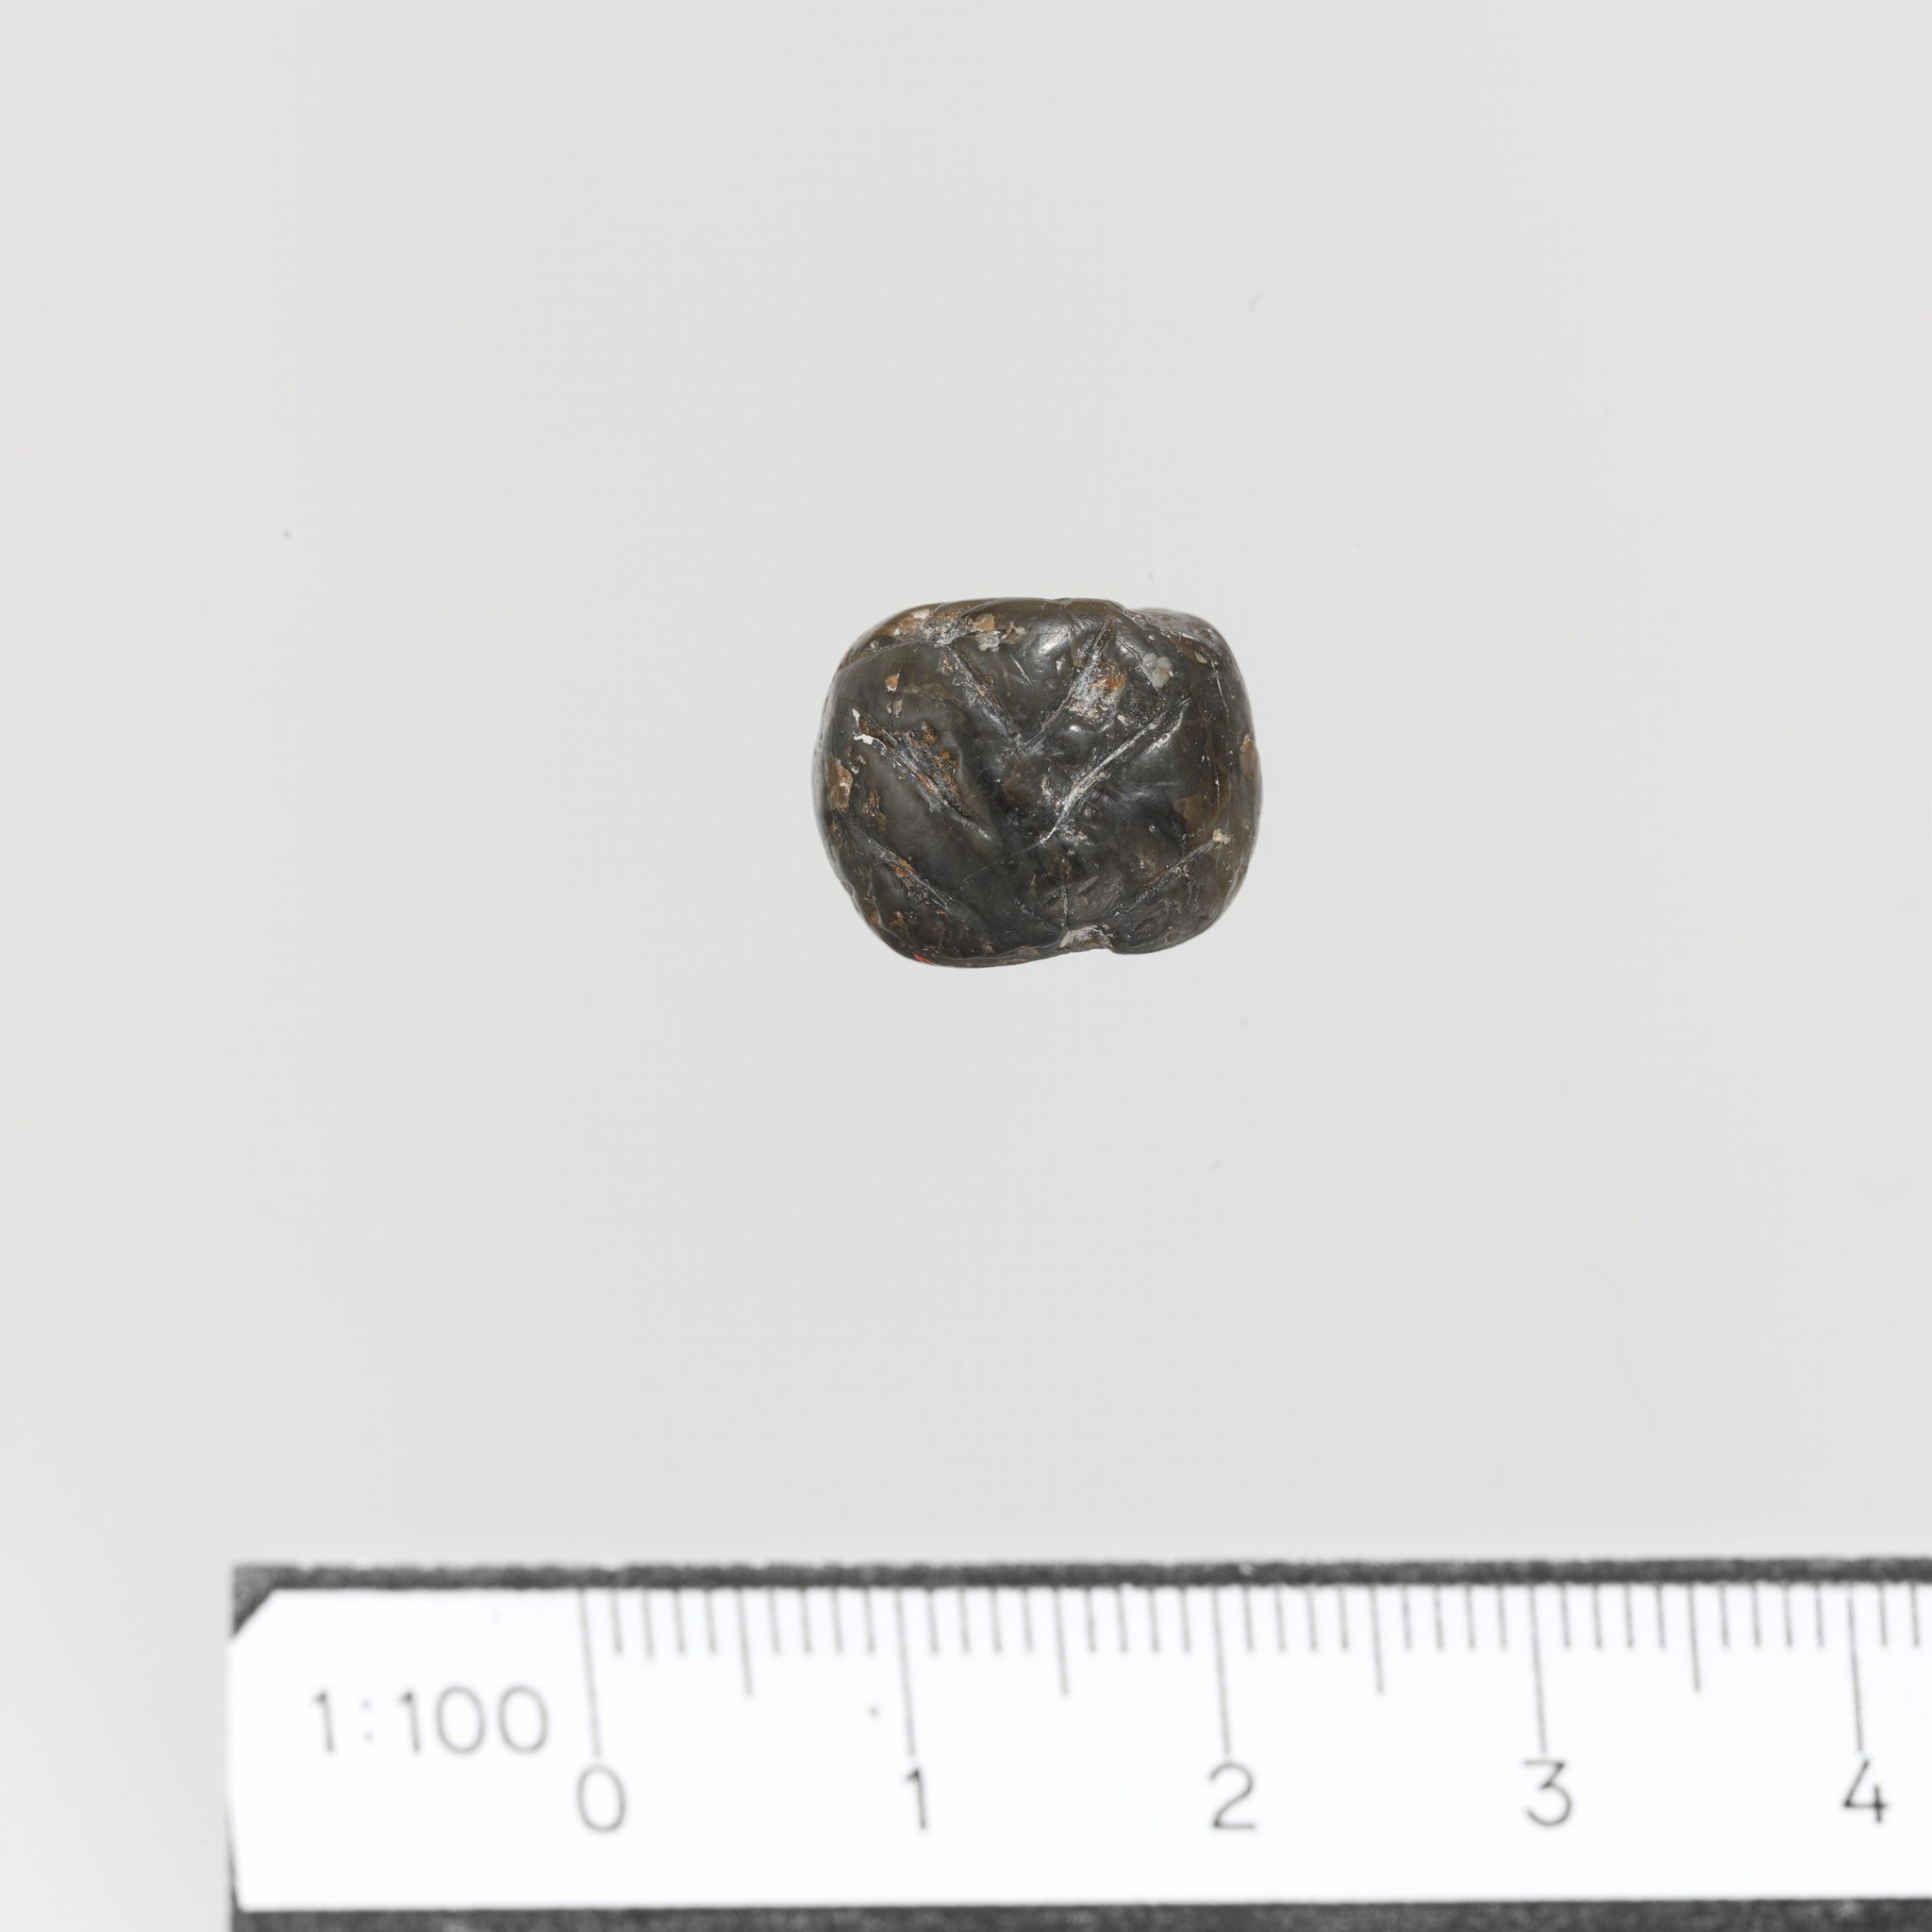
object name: seal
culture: minoan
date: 2600-2000 BCE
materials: stone